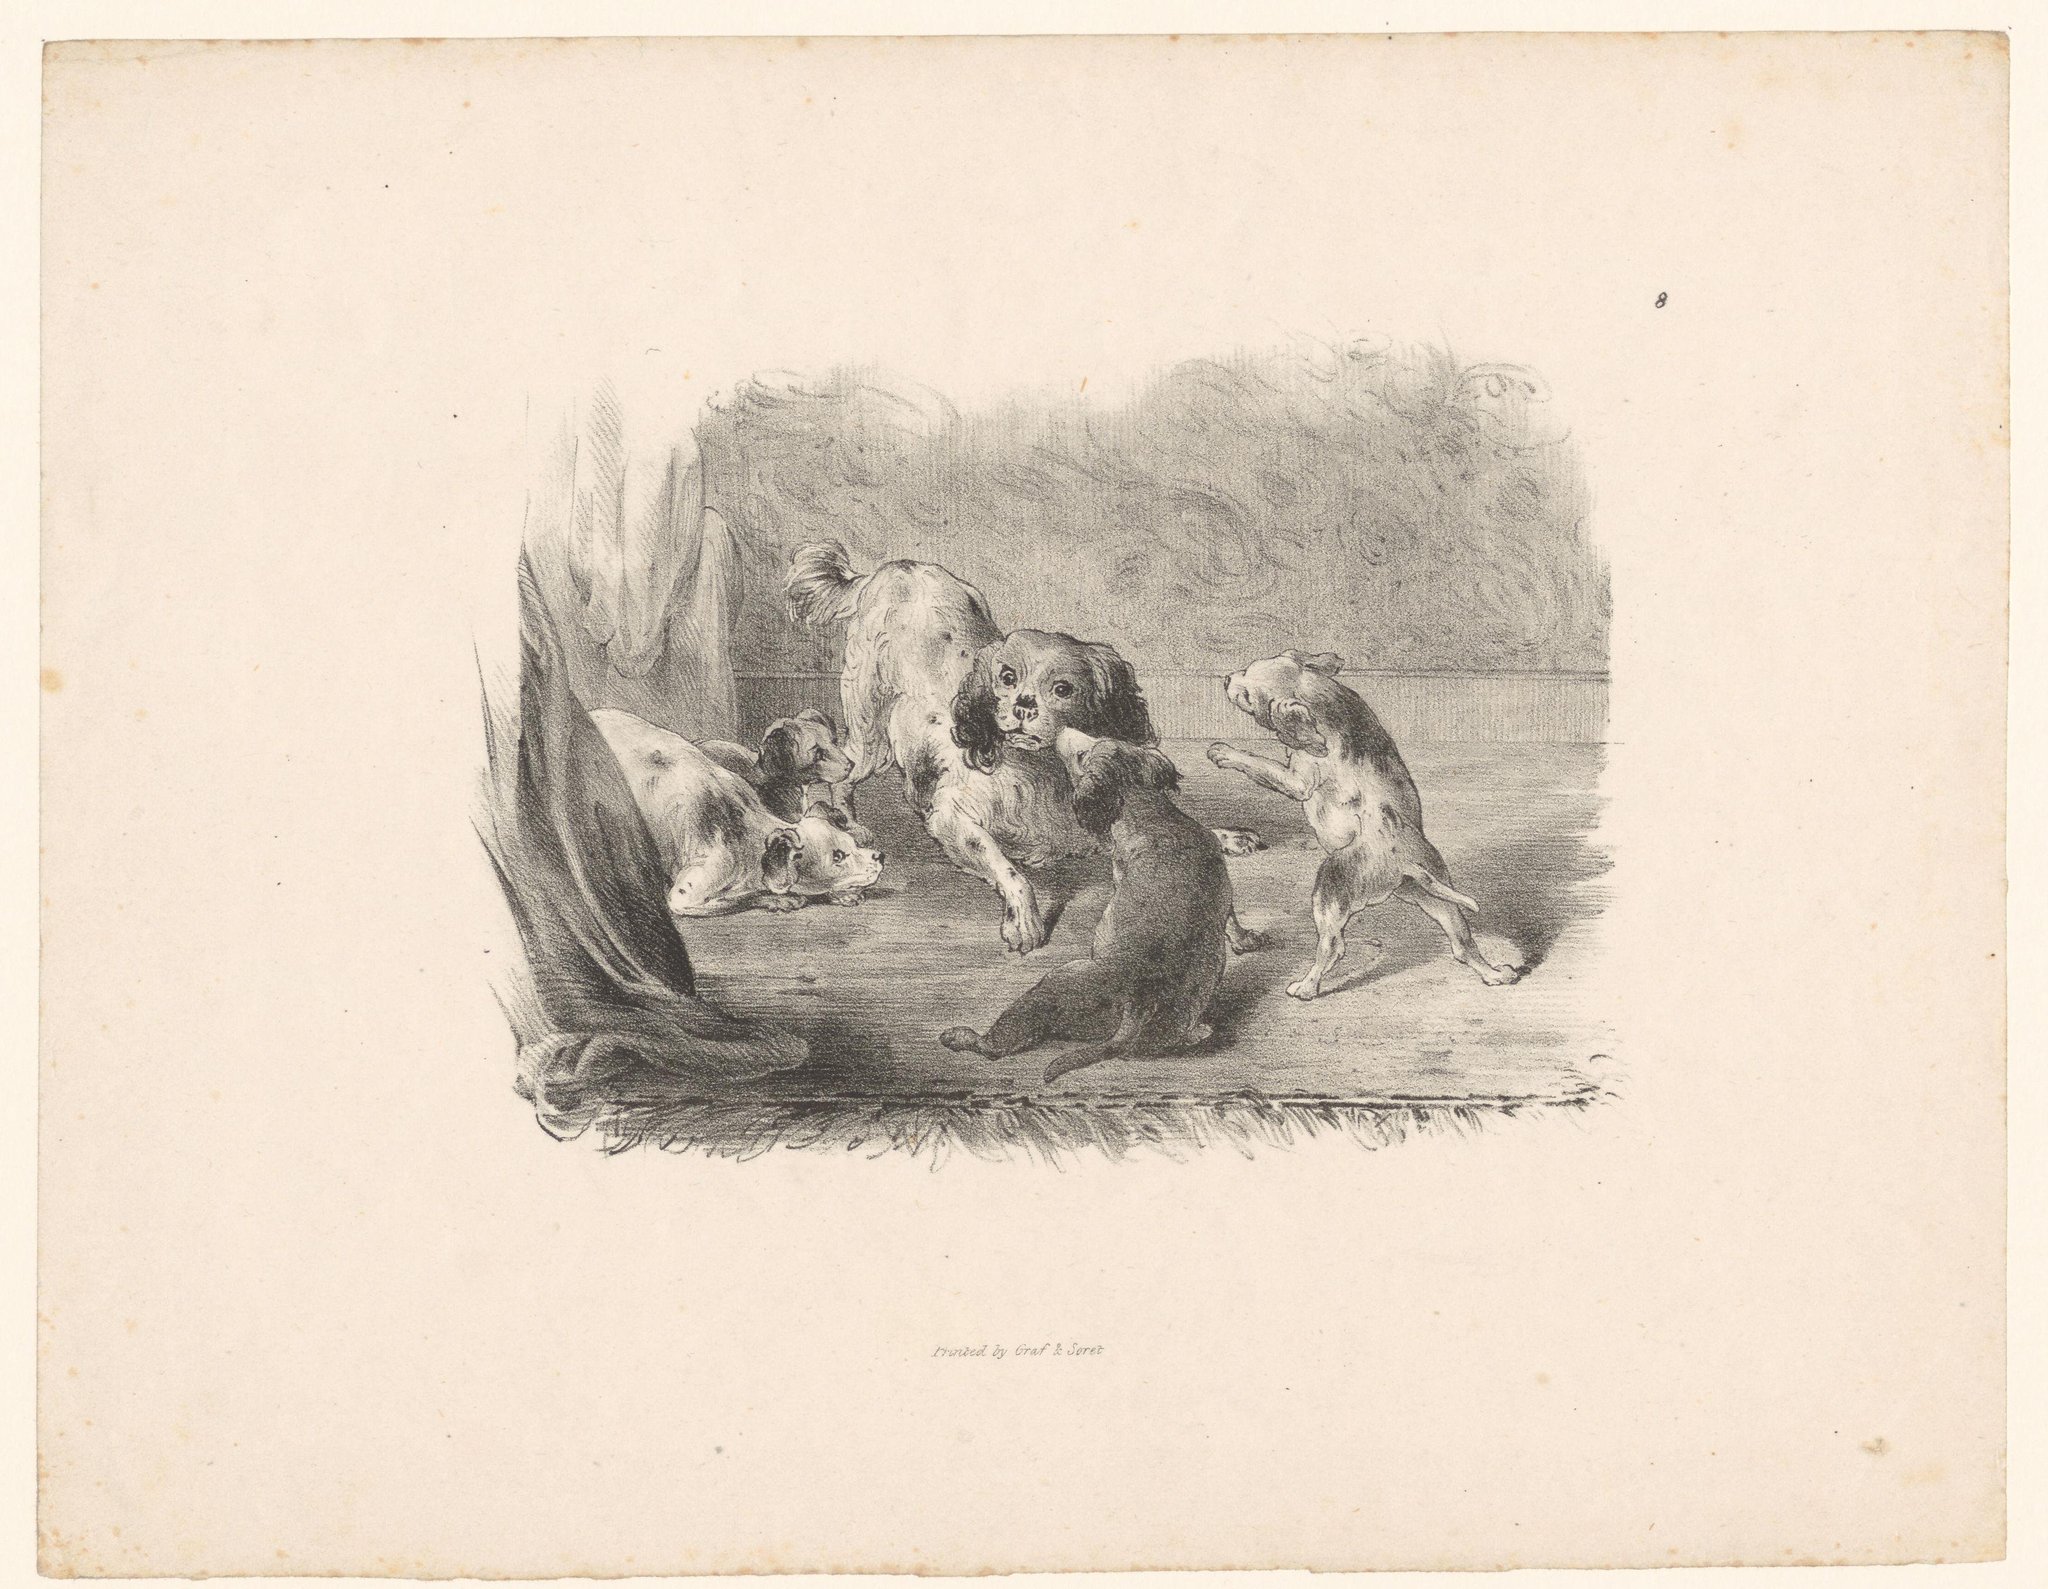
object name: print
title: Hond met vier puppies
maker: james henry lynch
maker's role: print maker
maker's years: -1868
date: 1830-1838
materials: paper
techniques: lithograph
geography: london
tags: dog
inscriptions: collector's mark: Lugt 2233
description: Prent maakt waarschijnlijk deel uit van een serie met diervoorstellingen. Over deze serie is verder niets bekend. Het betreft voornamelijk voorstellingen van honden.